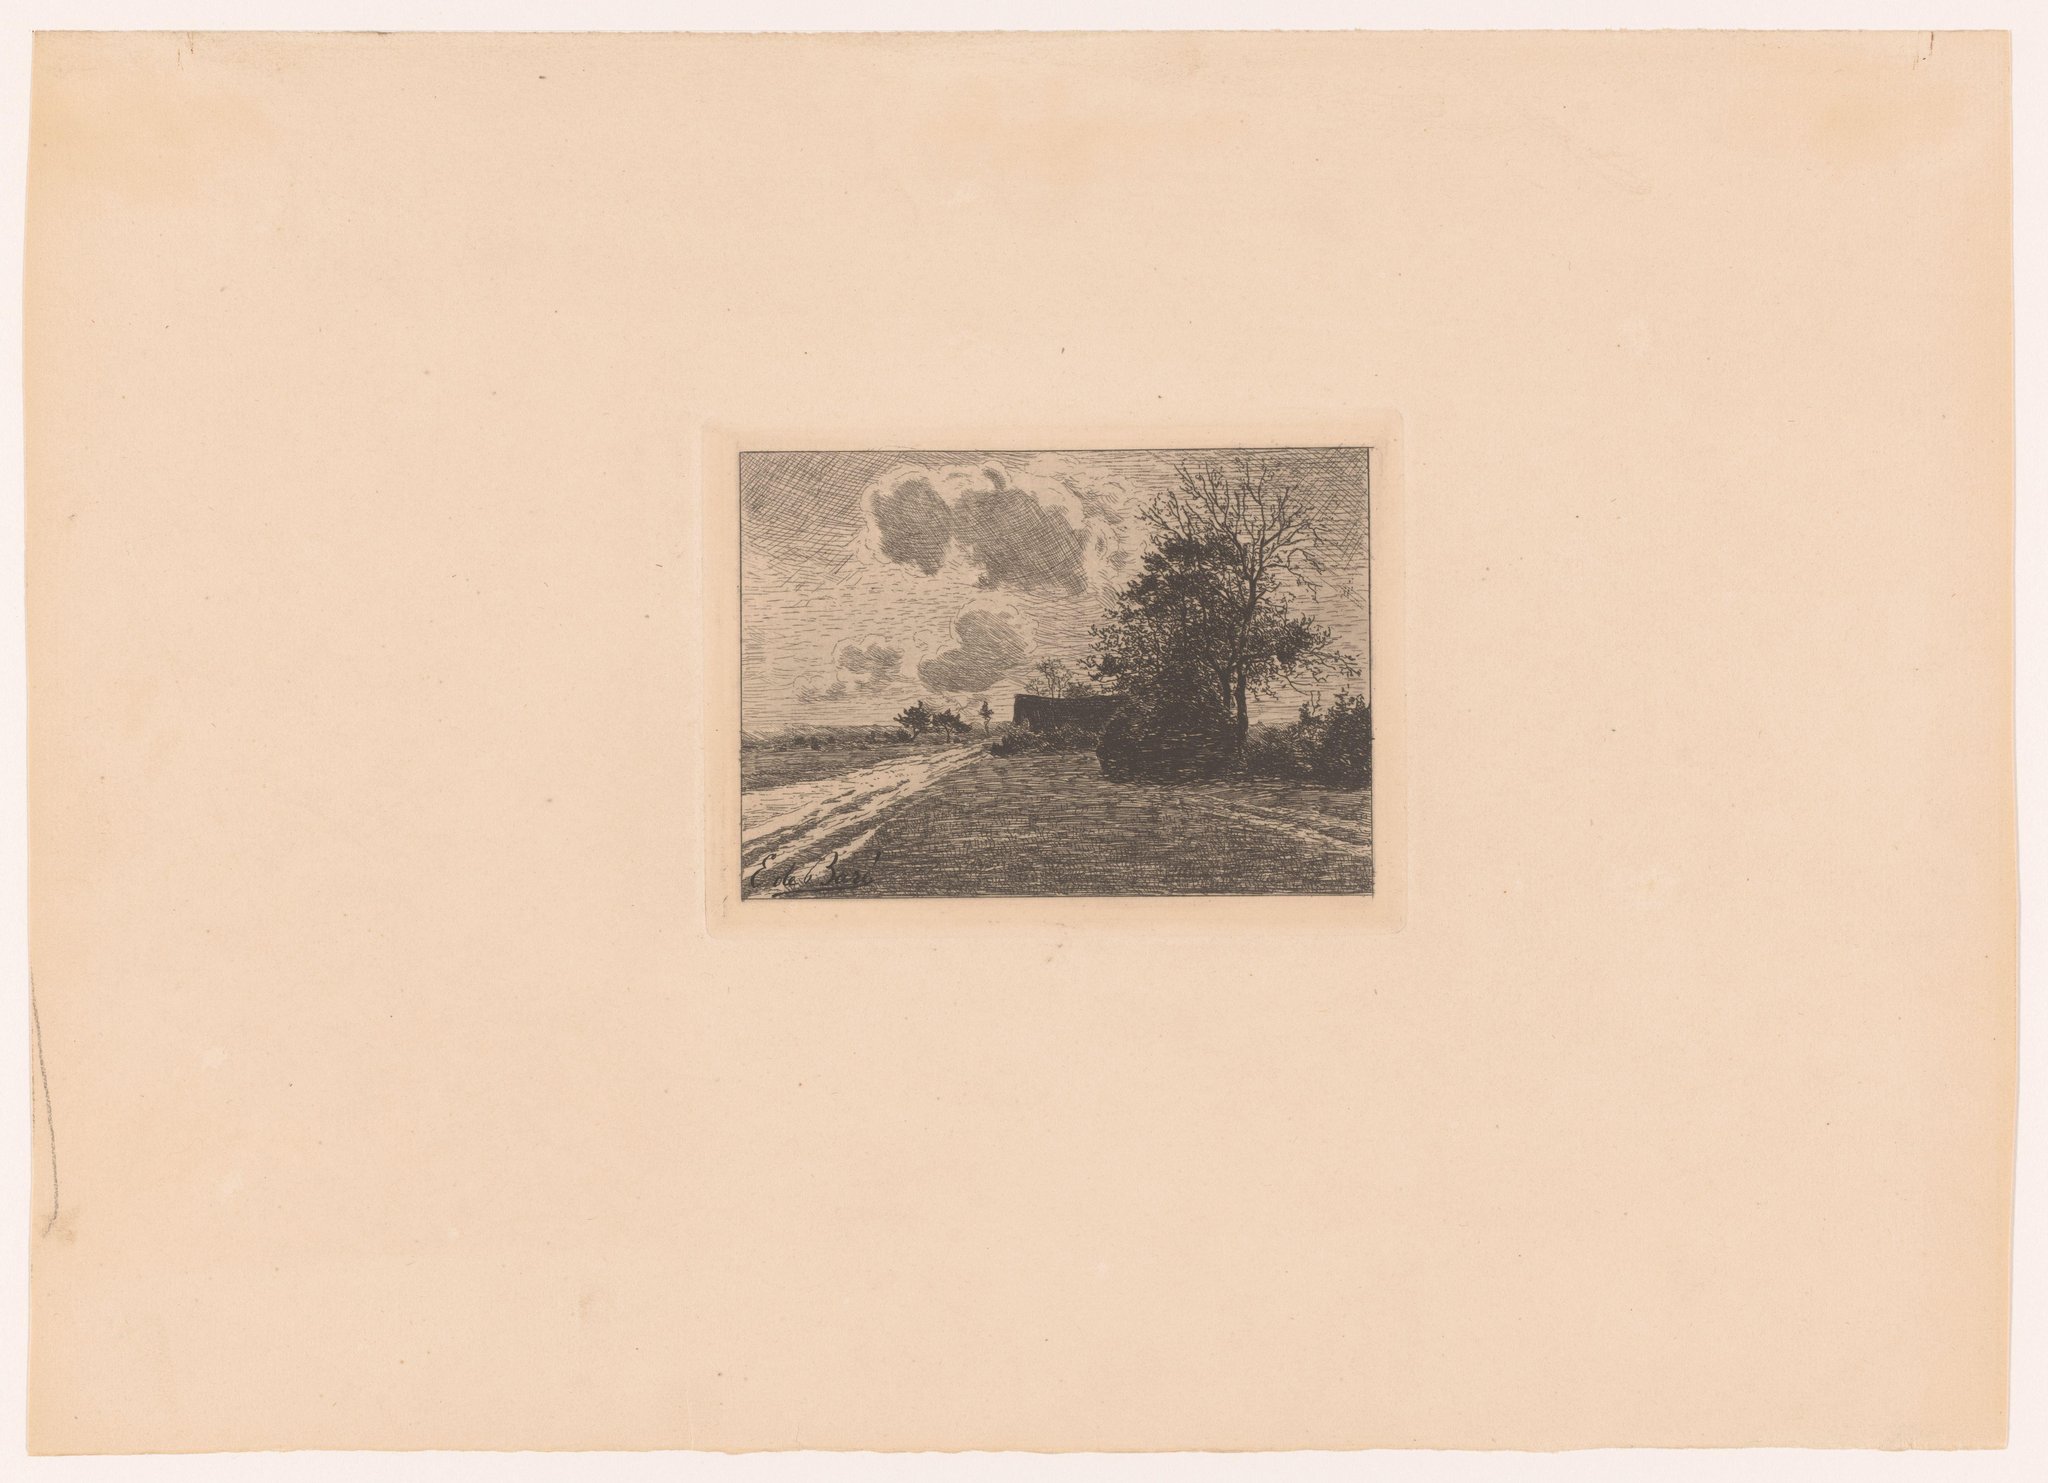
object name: print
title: Landweg met boerderij tussen bomen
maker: emile de baré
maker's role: painter, print maker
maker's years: 1855-1902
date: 1865-1902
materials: paper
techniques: etching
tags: farm or solitary house in landscape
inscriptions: collector's mark: Lugt 2228, watermark: ‘Van Gelder’